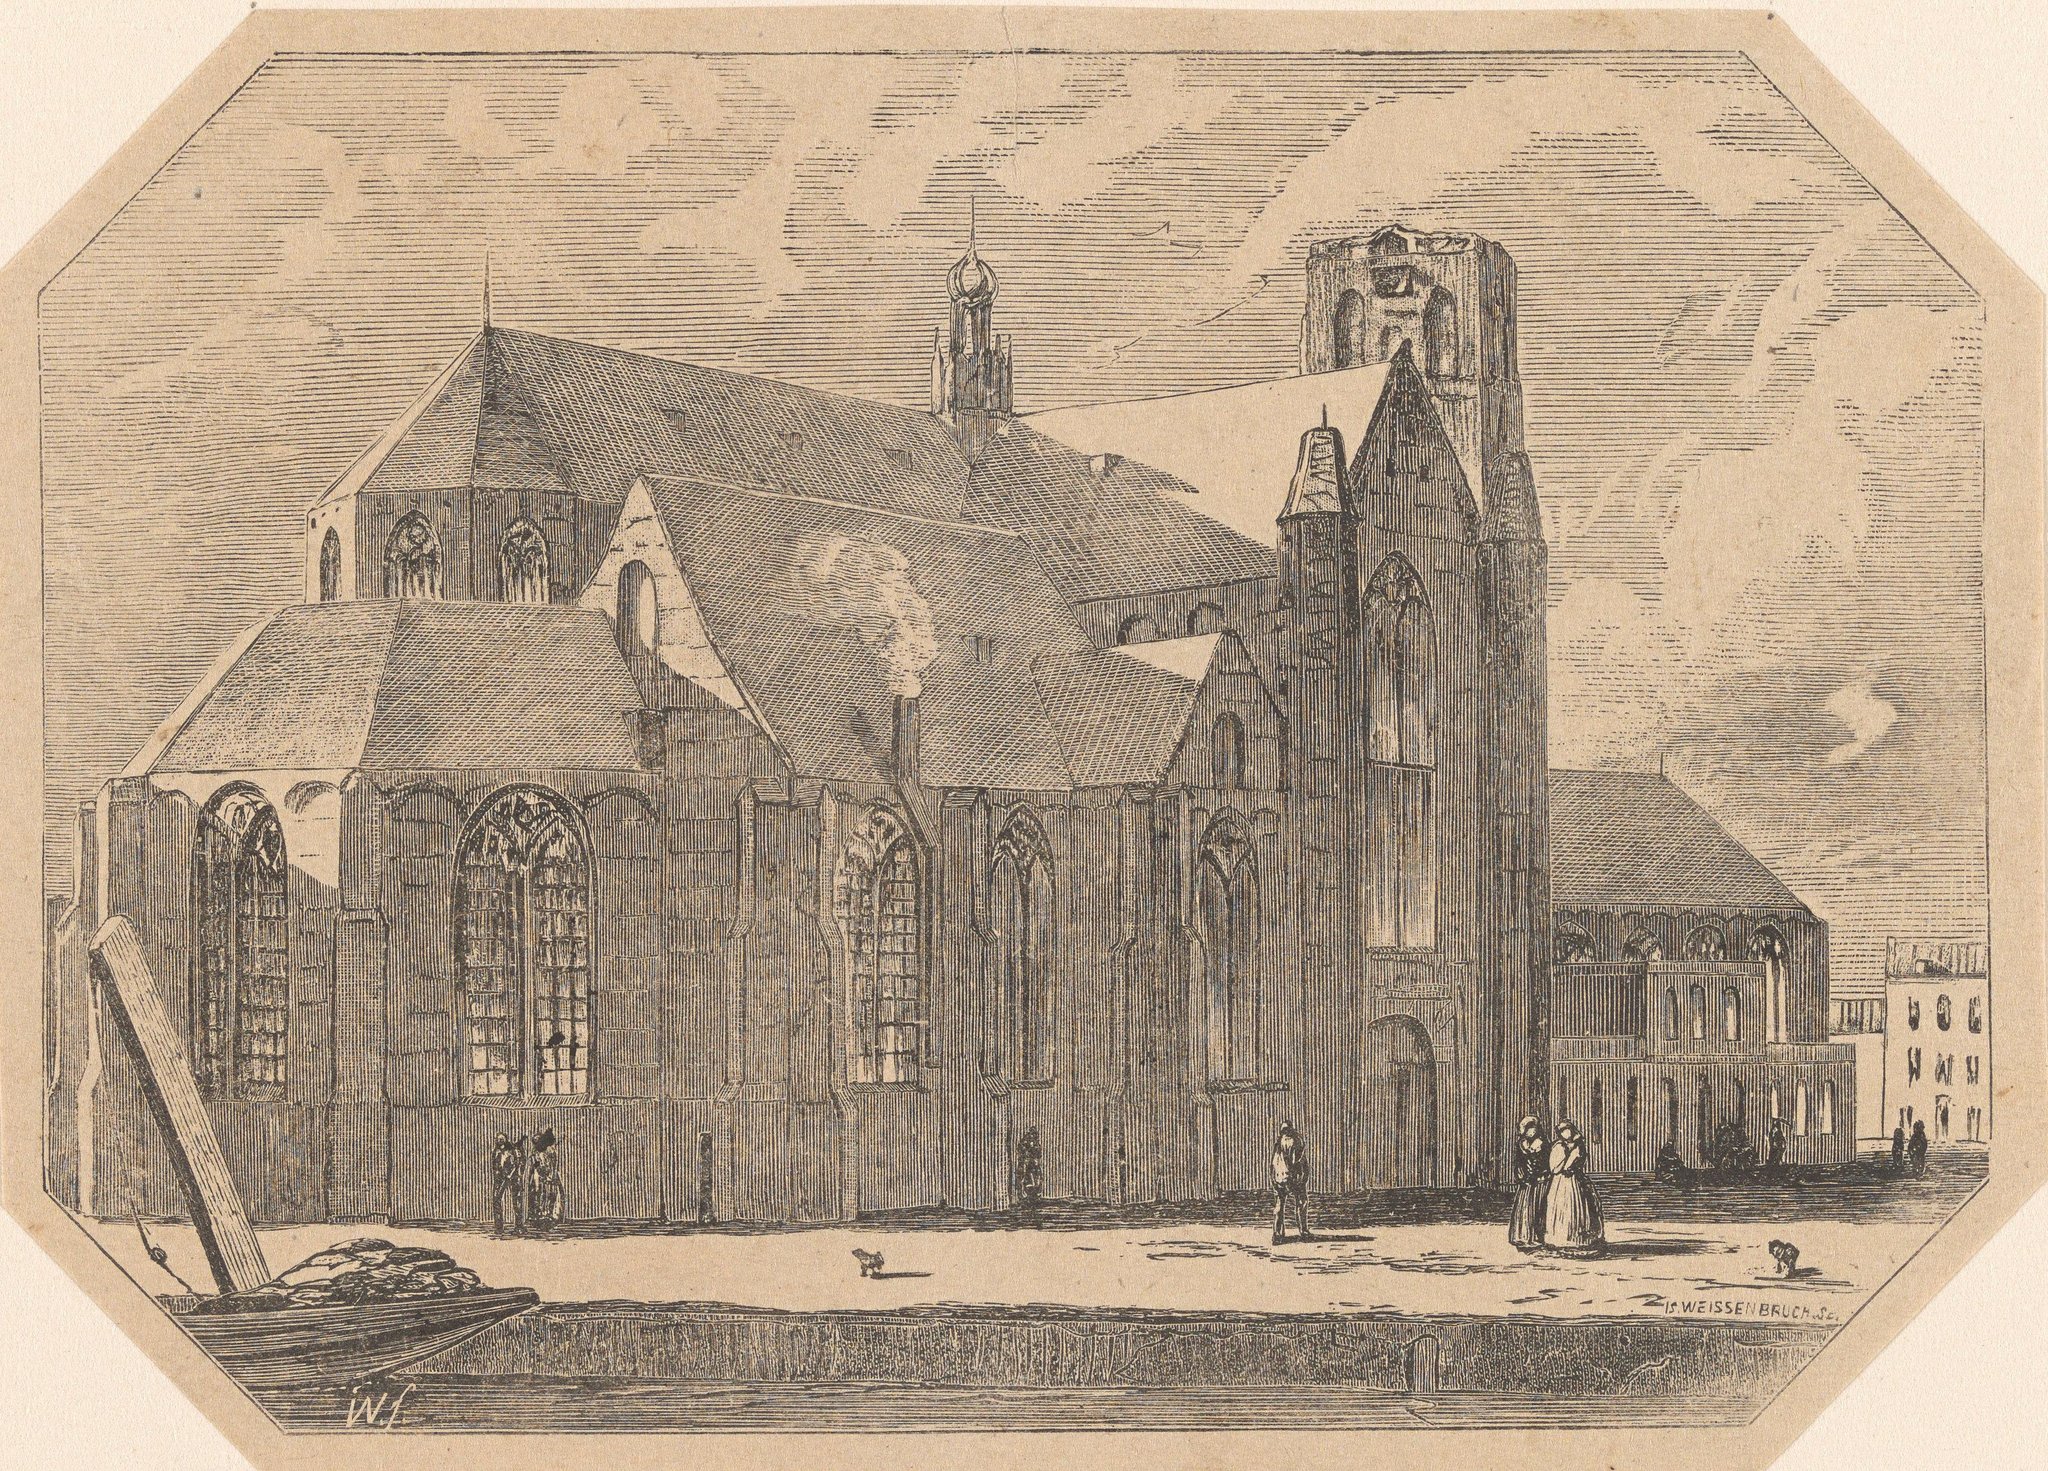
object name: print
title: Gezicht op een kerk met een plein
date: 1836-1912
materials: paper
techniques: engraving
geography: netherlands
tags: church (exterior), square, place, circus, etc. (+ city(-scape) with figures, staffage)